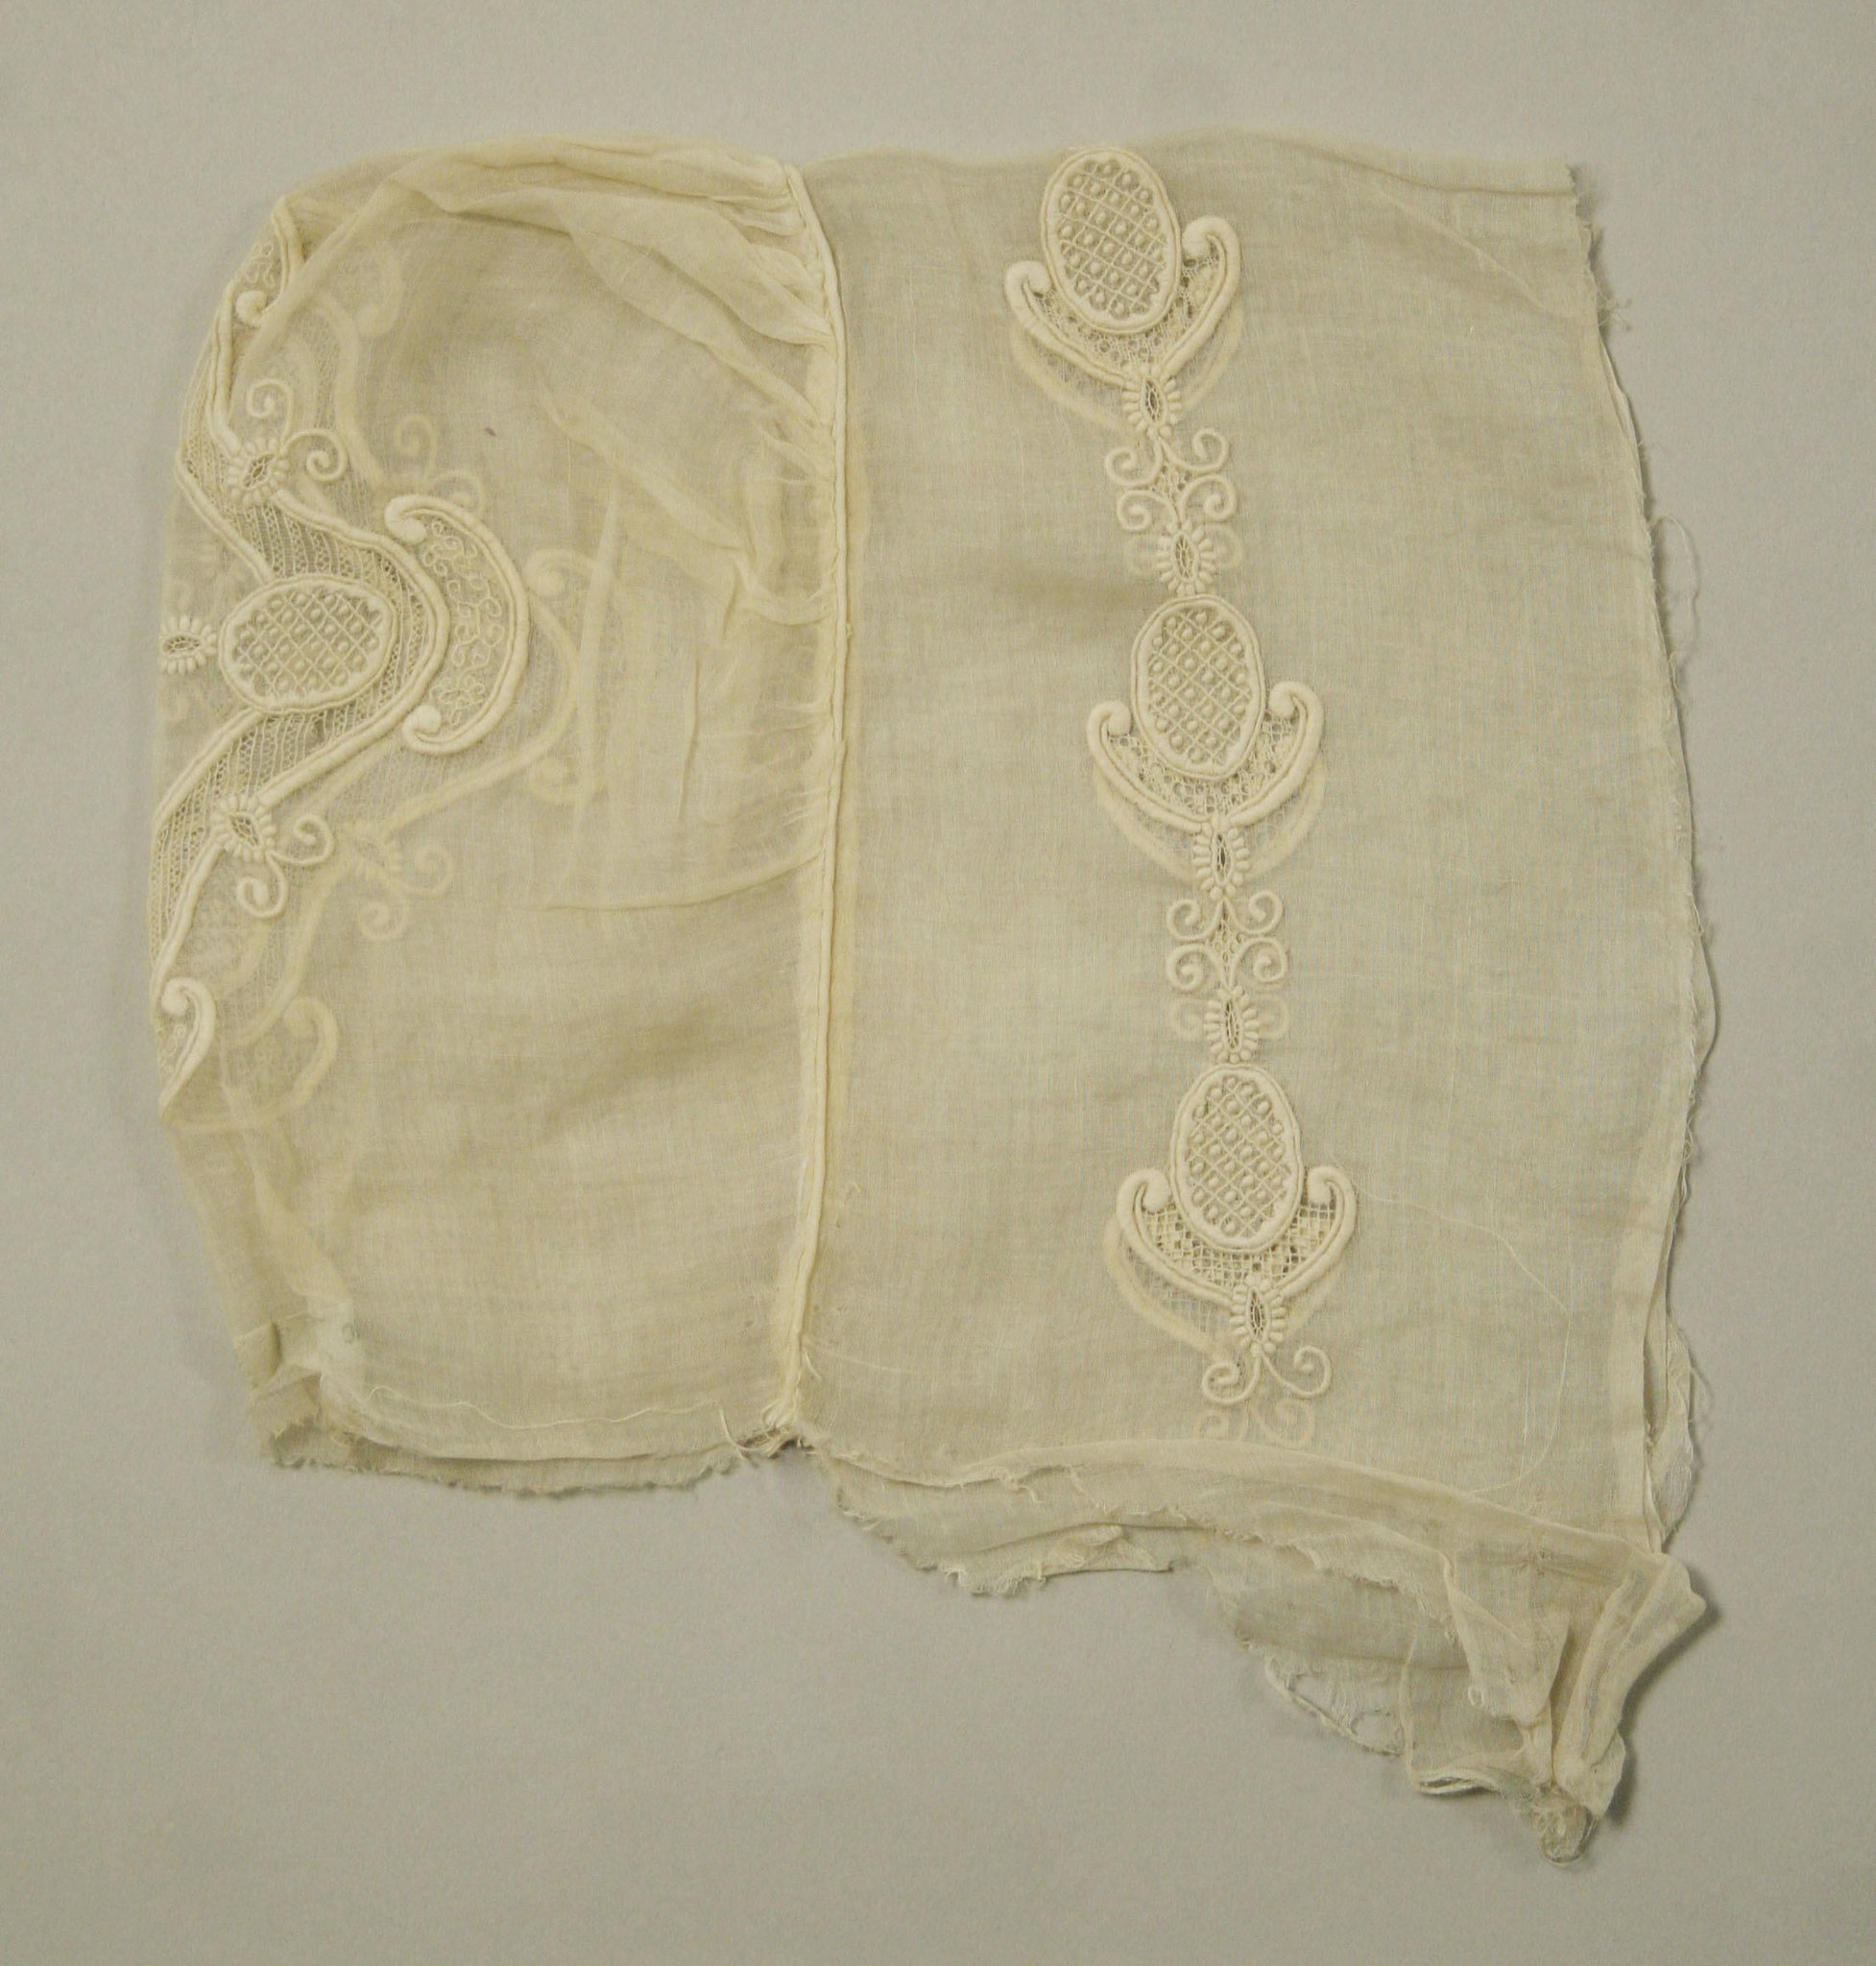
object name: cap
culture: british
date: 1801-1900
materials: cotton